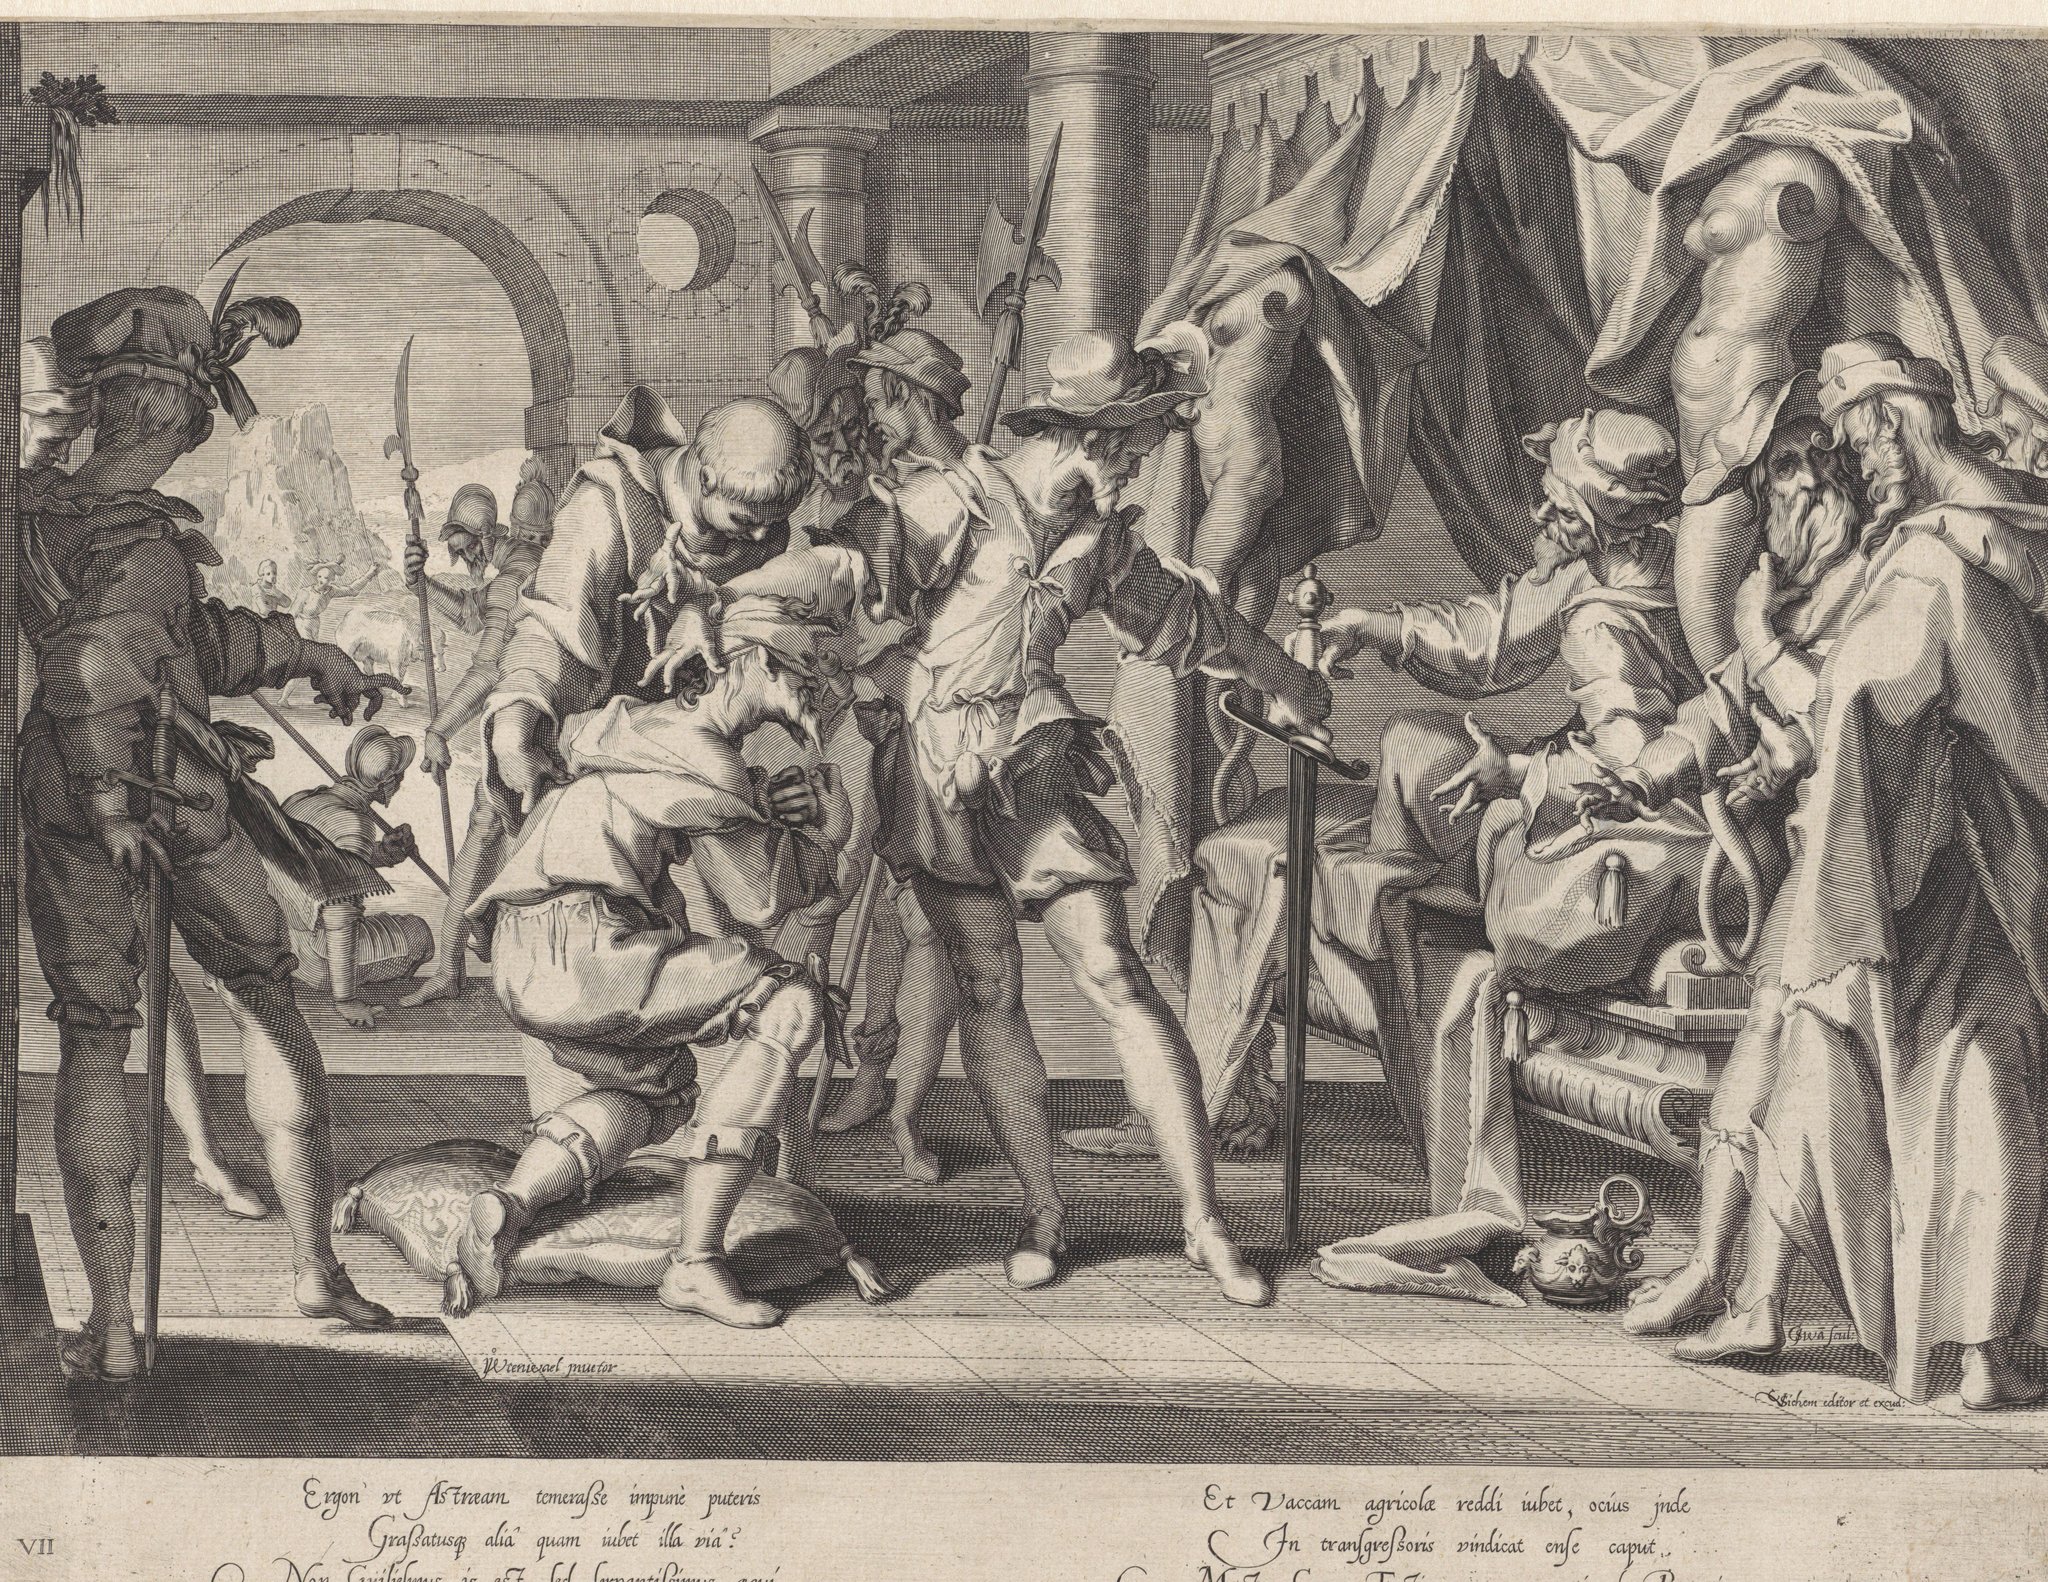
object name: print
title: Thronus Justitiae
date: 1606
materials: paper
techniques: engraving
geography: amsterdam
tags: willem iii de goede (graaf van holland en henegouwen), sick-bed, violent death by beheading, juridical examples; exemplary judges; 'gerechtigkeitsbilder'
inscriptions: collector's mark: Lugt 240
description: Willem III de Goede, graaf van Holland en Henegouwen, veroordeelt vanaf zijn ziekbed zijn baljuw en geeft opdracht hem te onthoofden. Op de achtergrond is de aanleiding te zien: de baljuw heeft een boer opgelicht door hem een slechte koe te verkopen voor een goede. Onder de voorstelling twee vierregelige verzen in het Latijn.